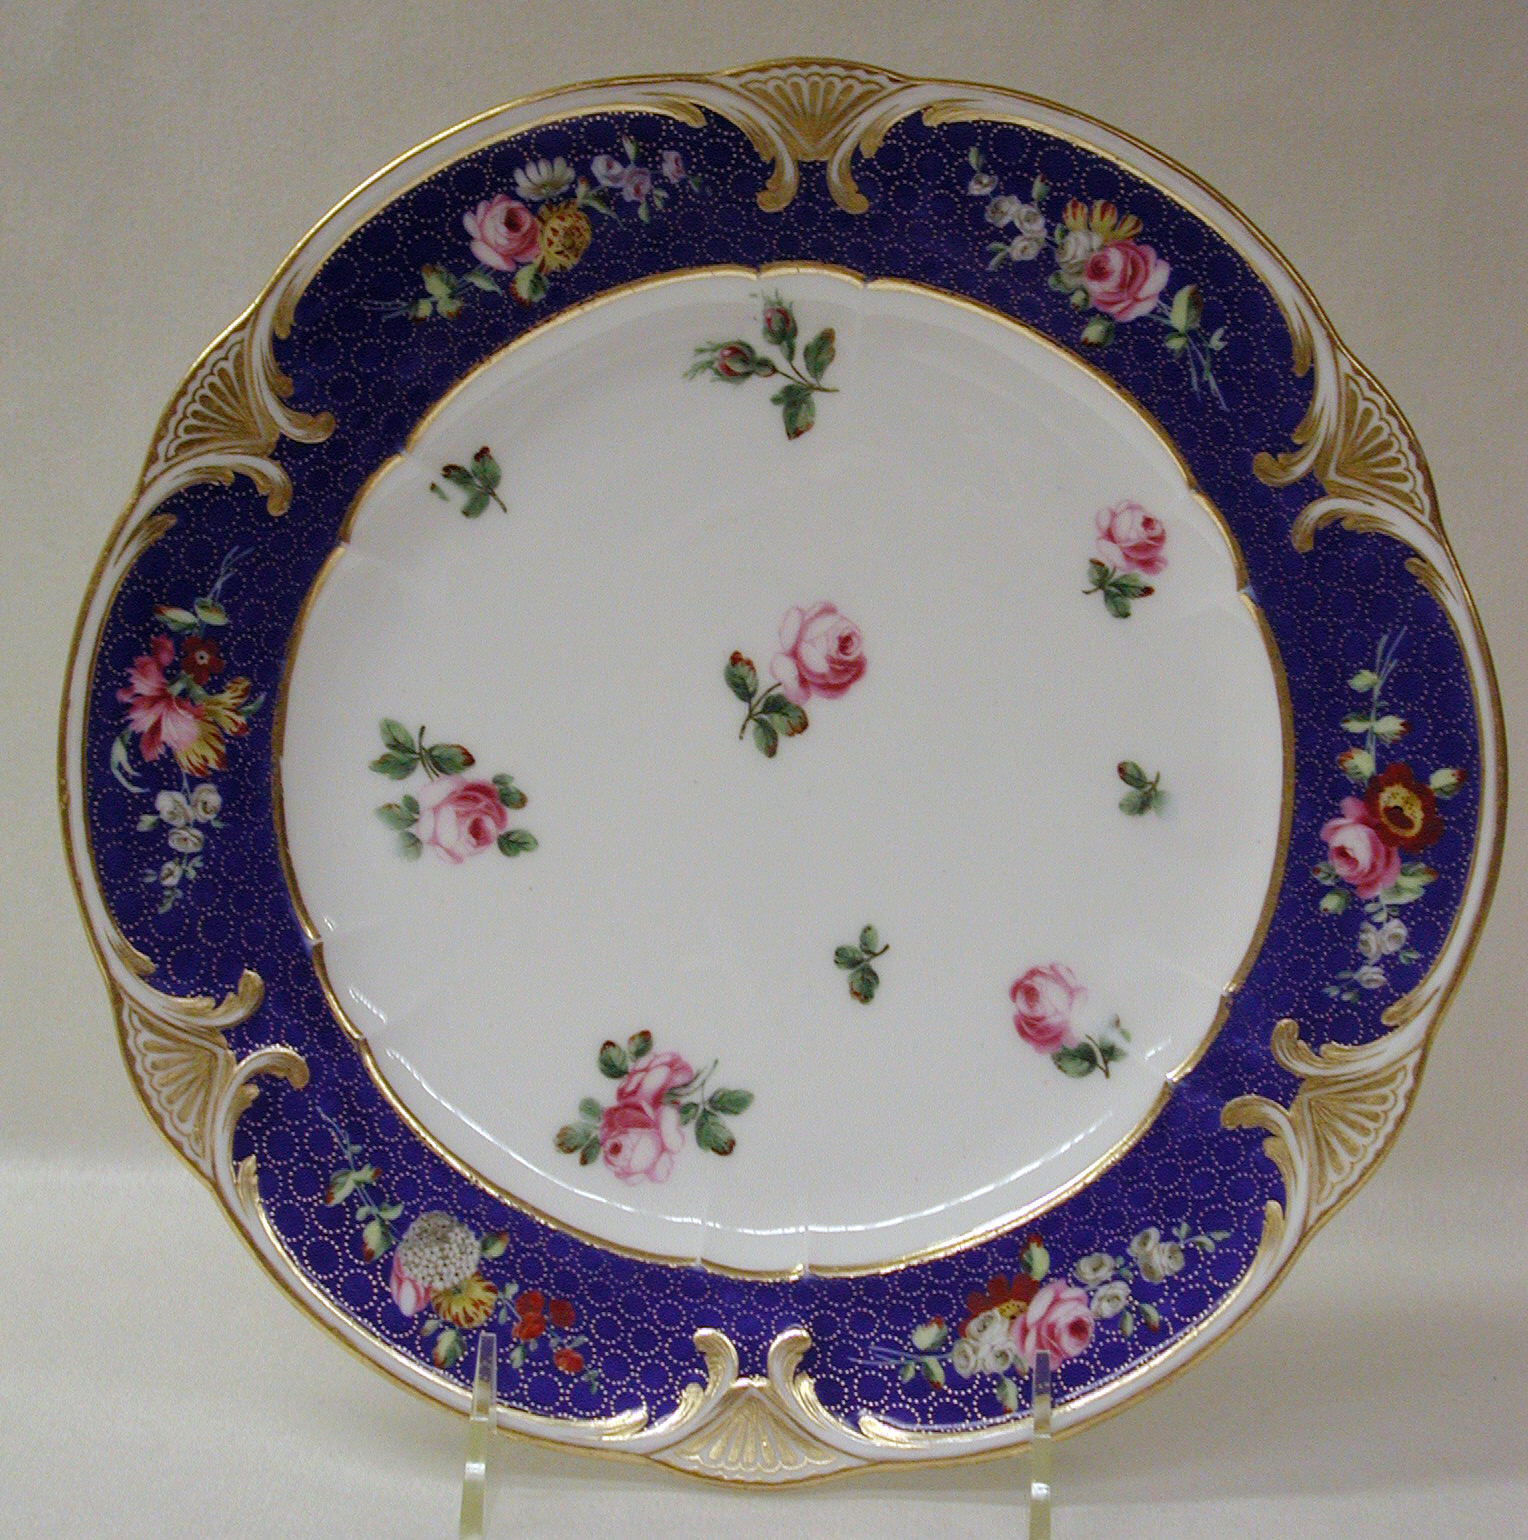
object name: plate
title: Plate (assiette à palmes)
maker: sèvres manufactory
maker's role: manufactory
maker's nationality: french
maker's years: 1740-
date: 1771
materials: soft paste porcelain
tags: flowers